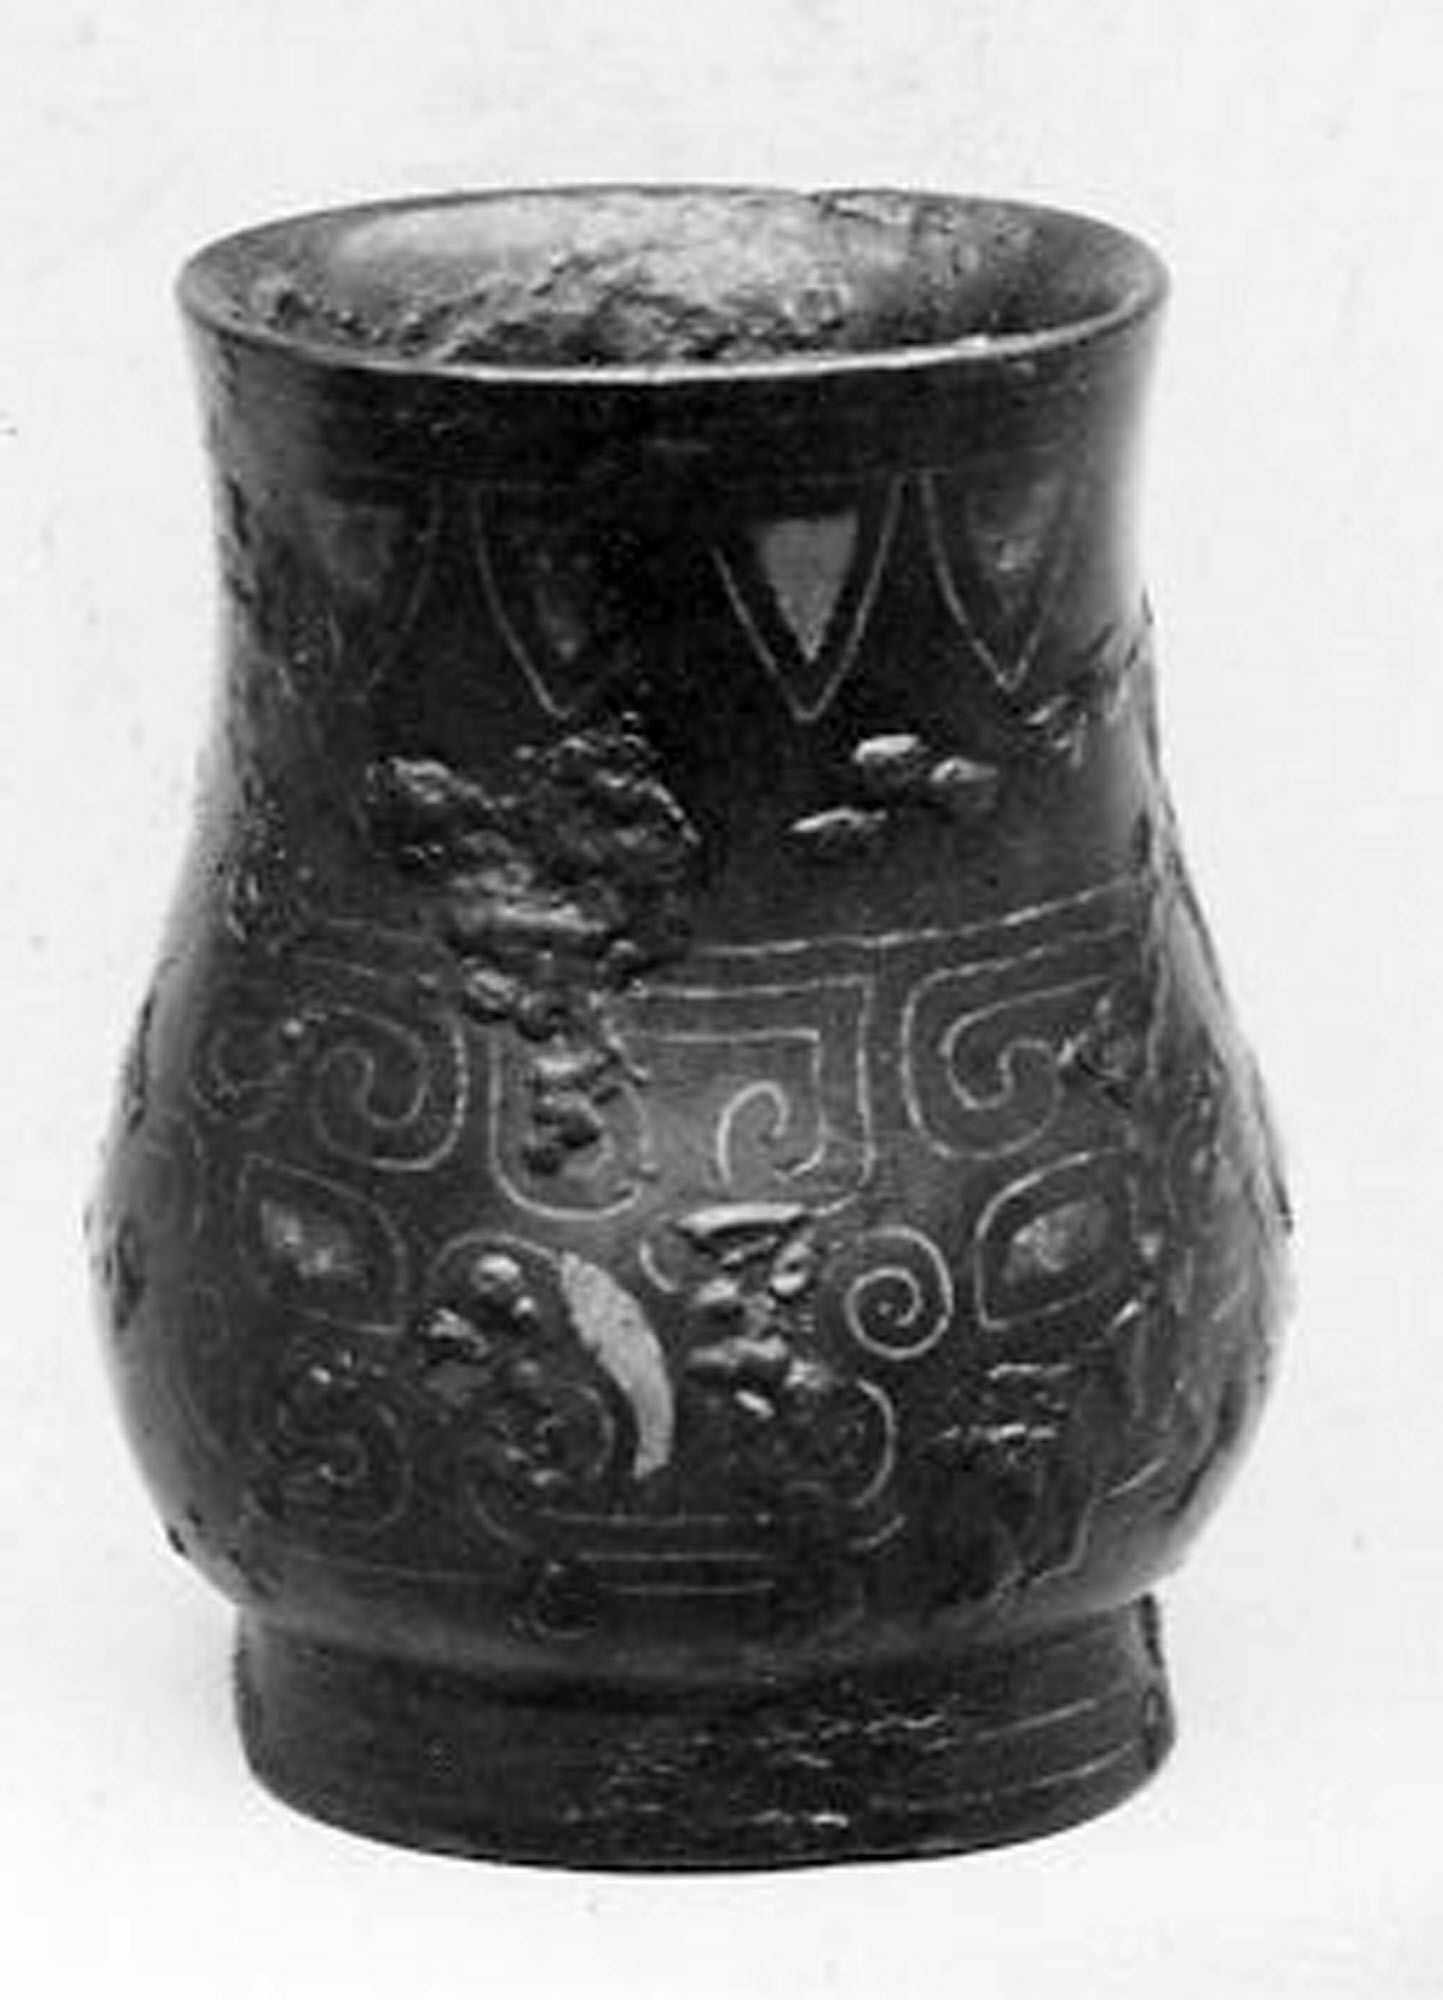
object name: vase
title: Miniature Vase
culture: chinese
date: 1801-1900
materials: bronze, silver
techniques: inlay